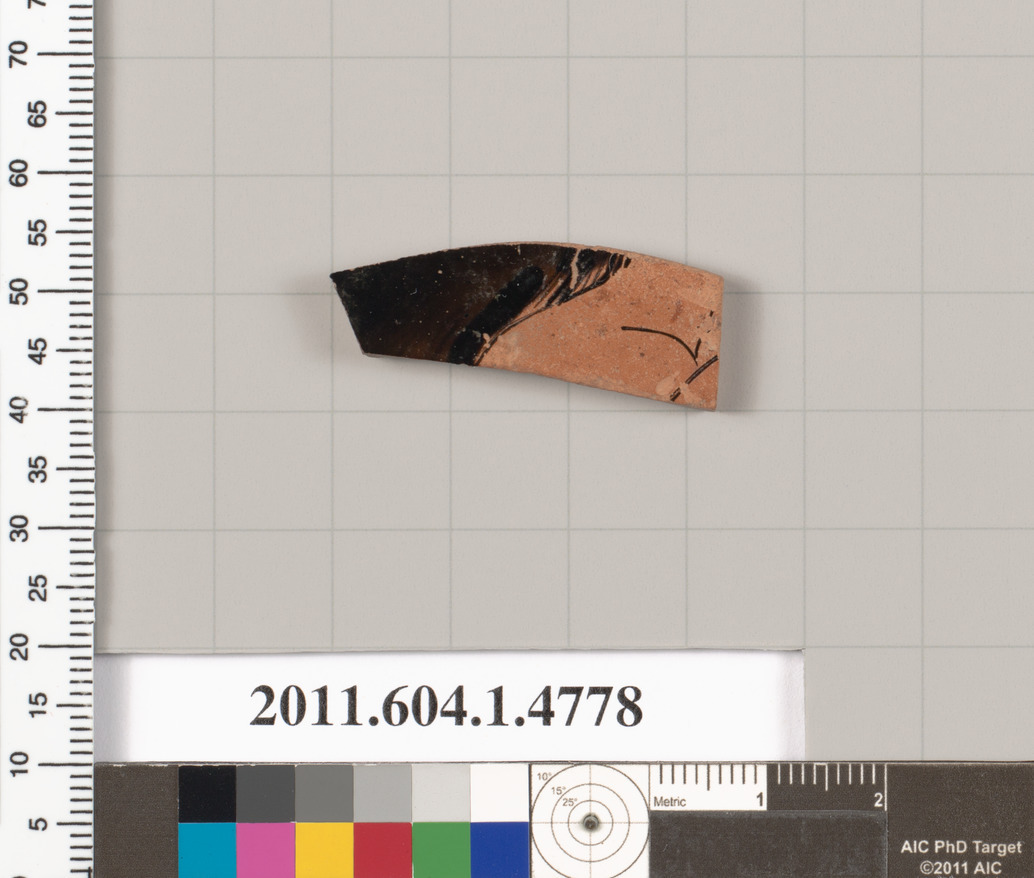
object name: kylix fragment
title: Terracotta fragment of a kylix (drinking cup)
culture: greek, attic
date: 475-451 BCE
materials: terracotta